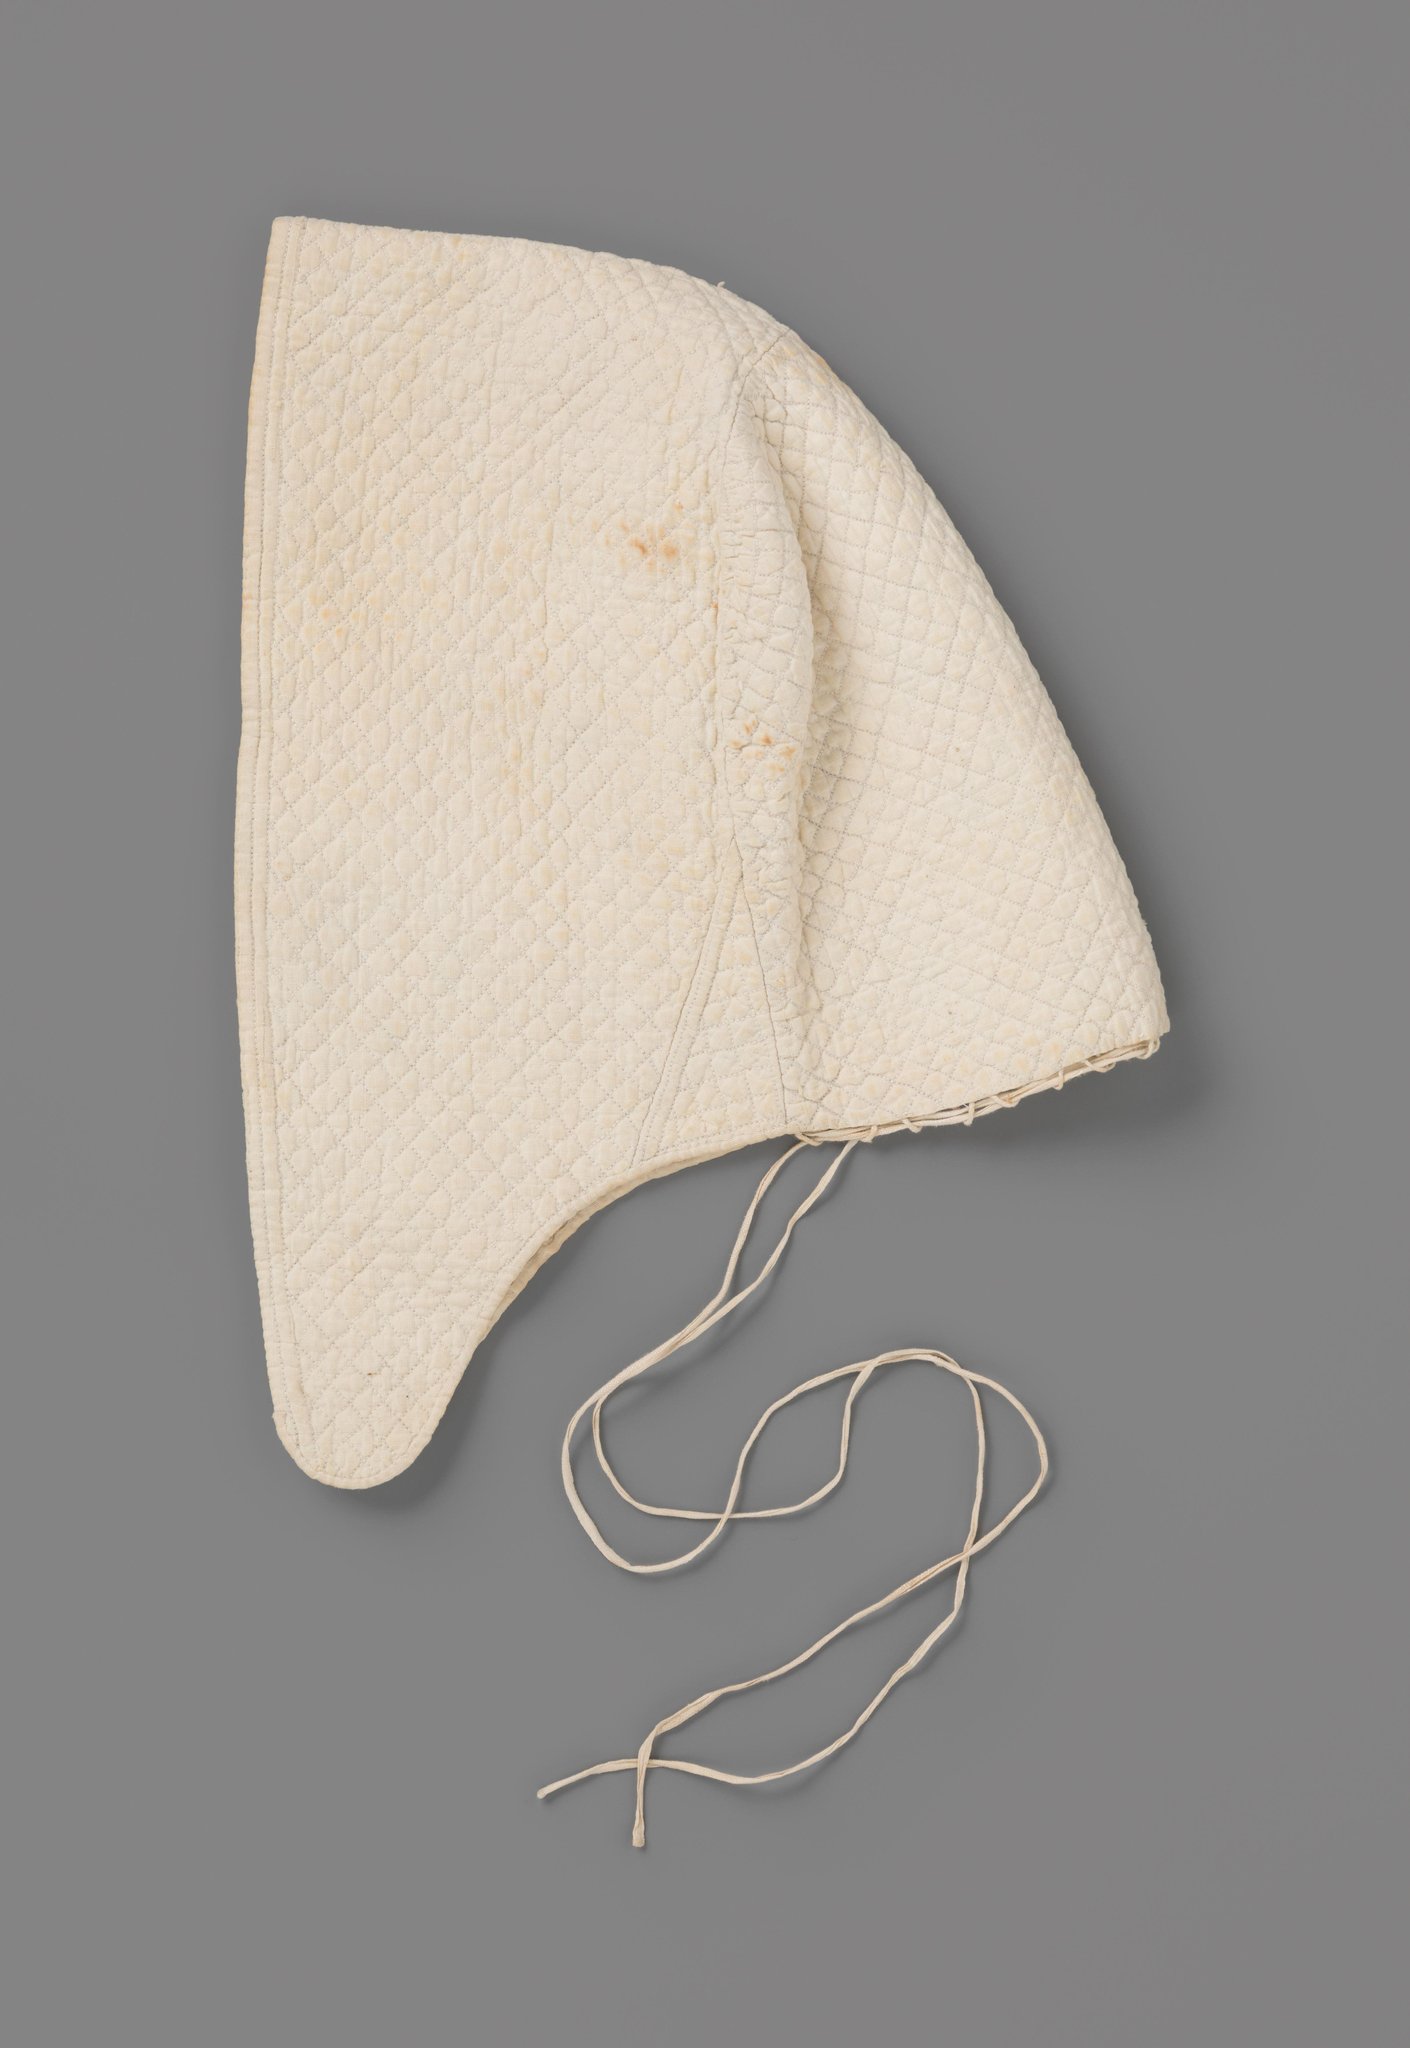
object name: cap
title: Muts van linnen met een patroon van ruiten in doorstikwerk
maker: Anonymous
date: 1600-1699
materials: linen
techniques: quilting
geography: netherlands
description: Gestikte muts. Een rechthoekig voorstuk, dat in ronde punten eindigt, is grotendeels aan de bol genaaid, slechts aan onderen is een drie-hoekig tussenstuk ingenaaid. De bol kan van onderen door middel van een band ingetrokken worden.